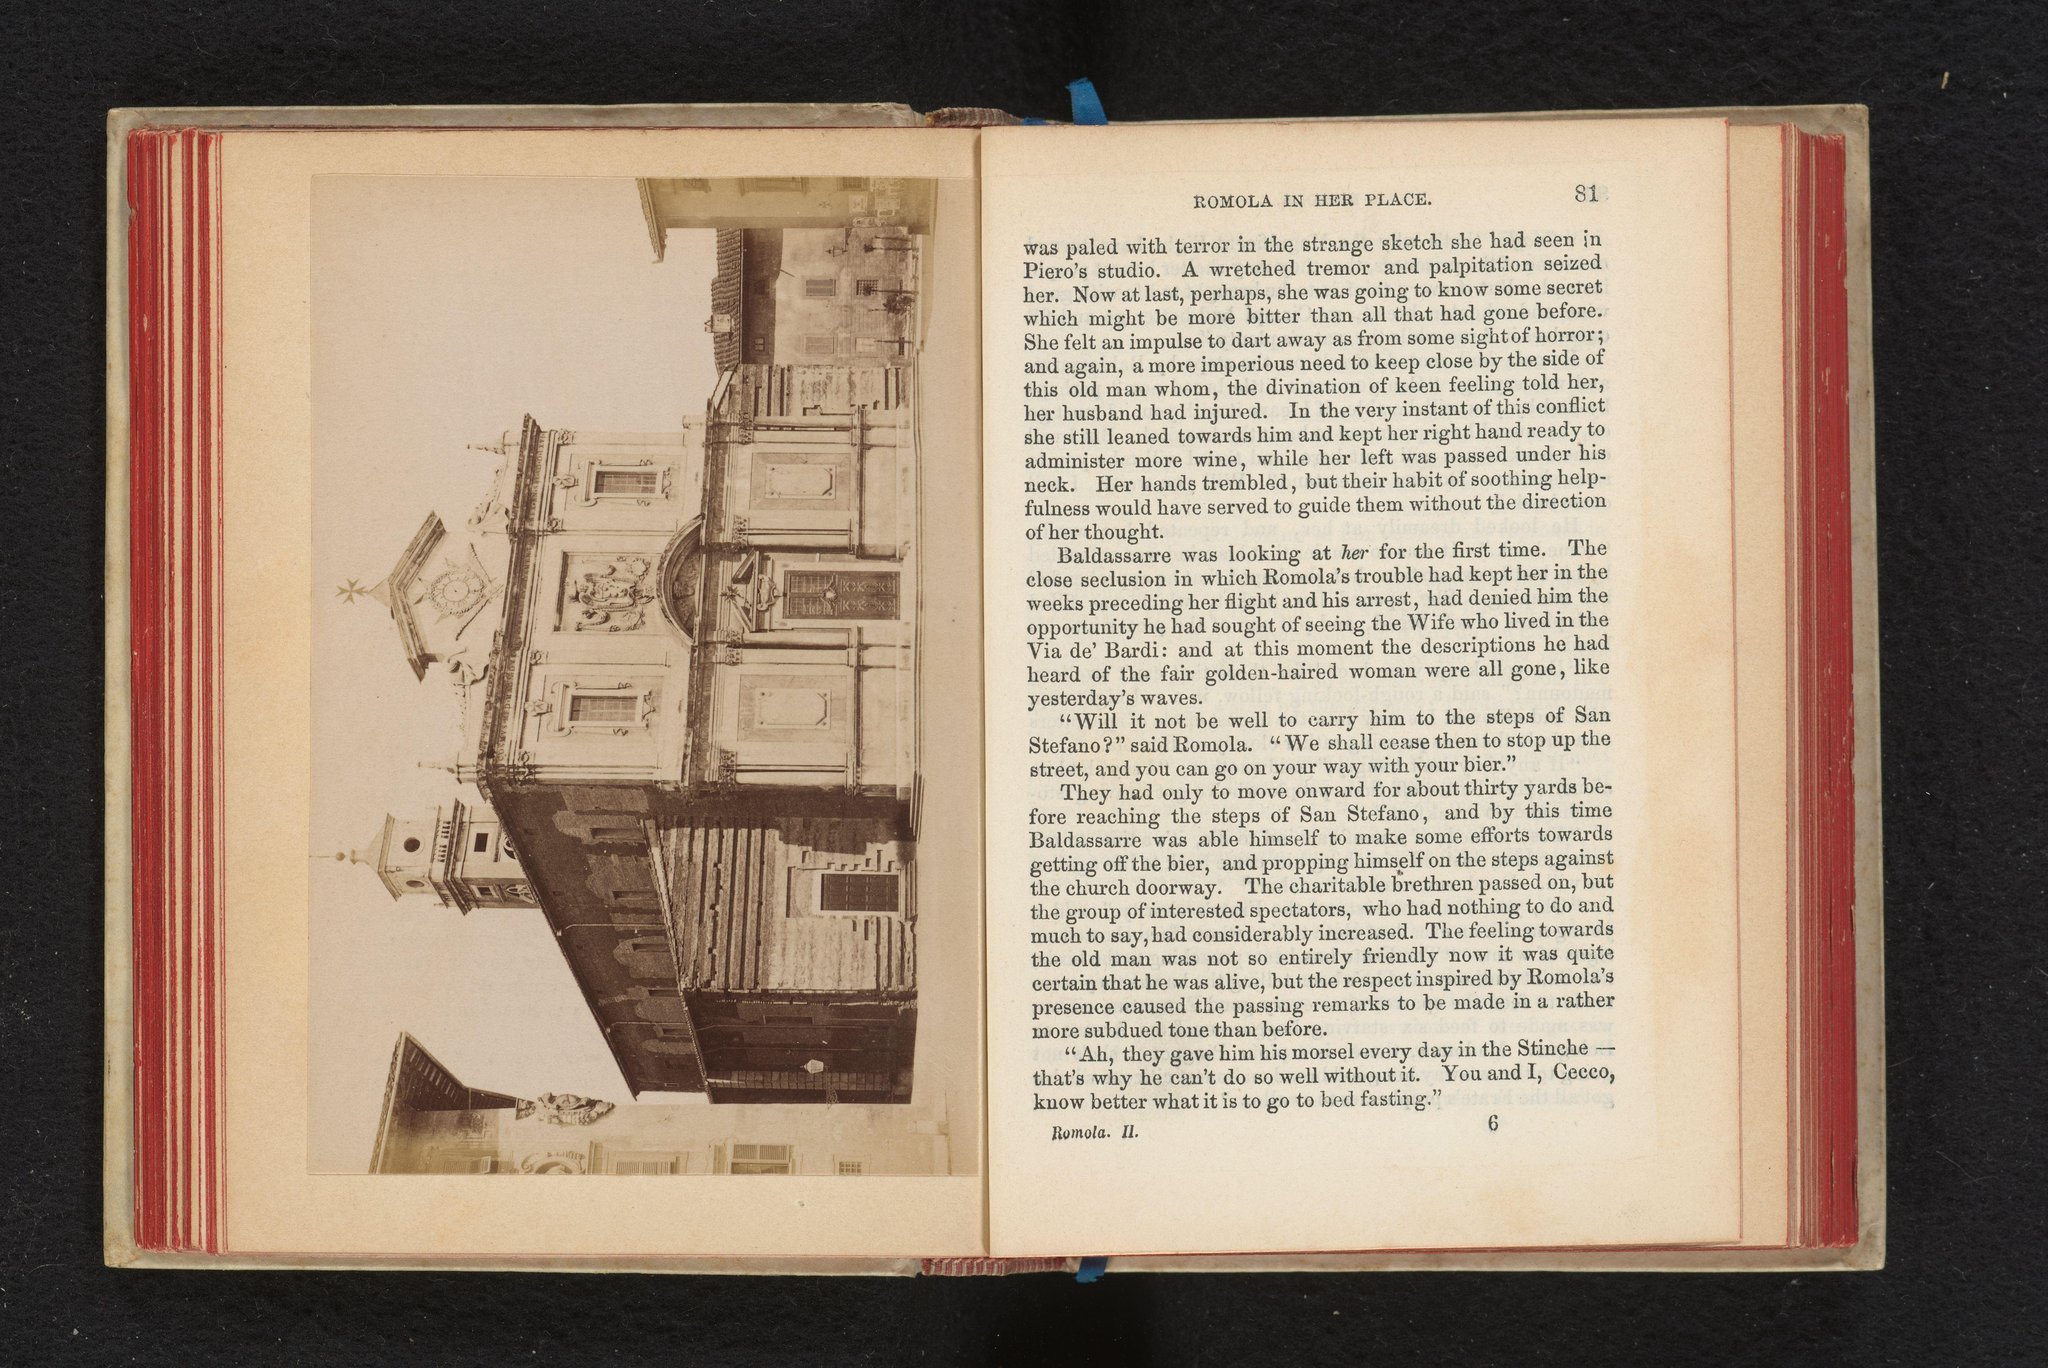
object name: photograph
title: Kerk van Santo Stefano dei Cavalieri, Pisa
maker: giacomo brogi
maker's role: fotograaf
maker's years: 1822-1881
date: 1858-1863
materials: paper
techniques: albumen print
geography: pisa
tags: church (exterior)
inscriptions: name: ‘Brogi’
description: Foto op ongenummerde pagina tegenover pagina 81.